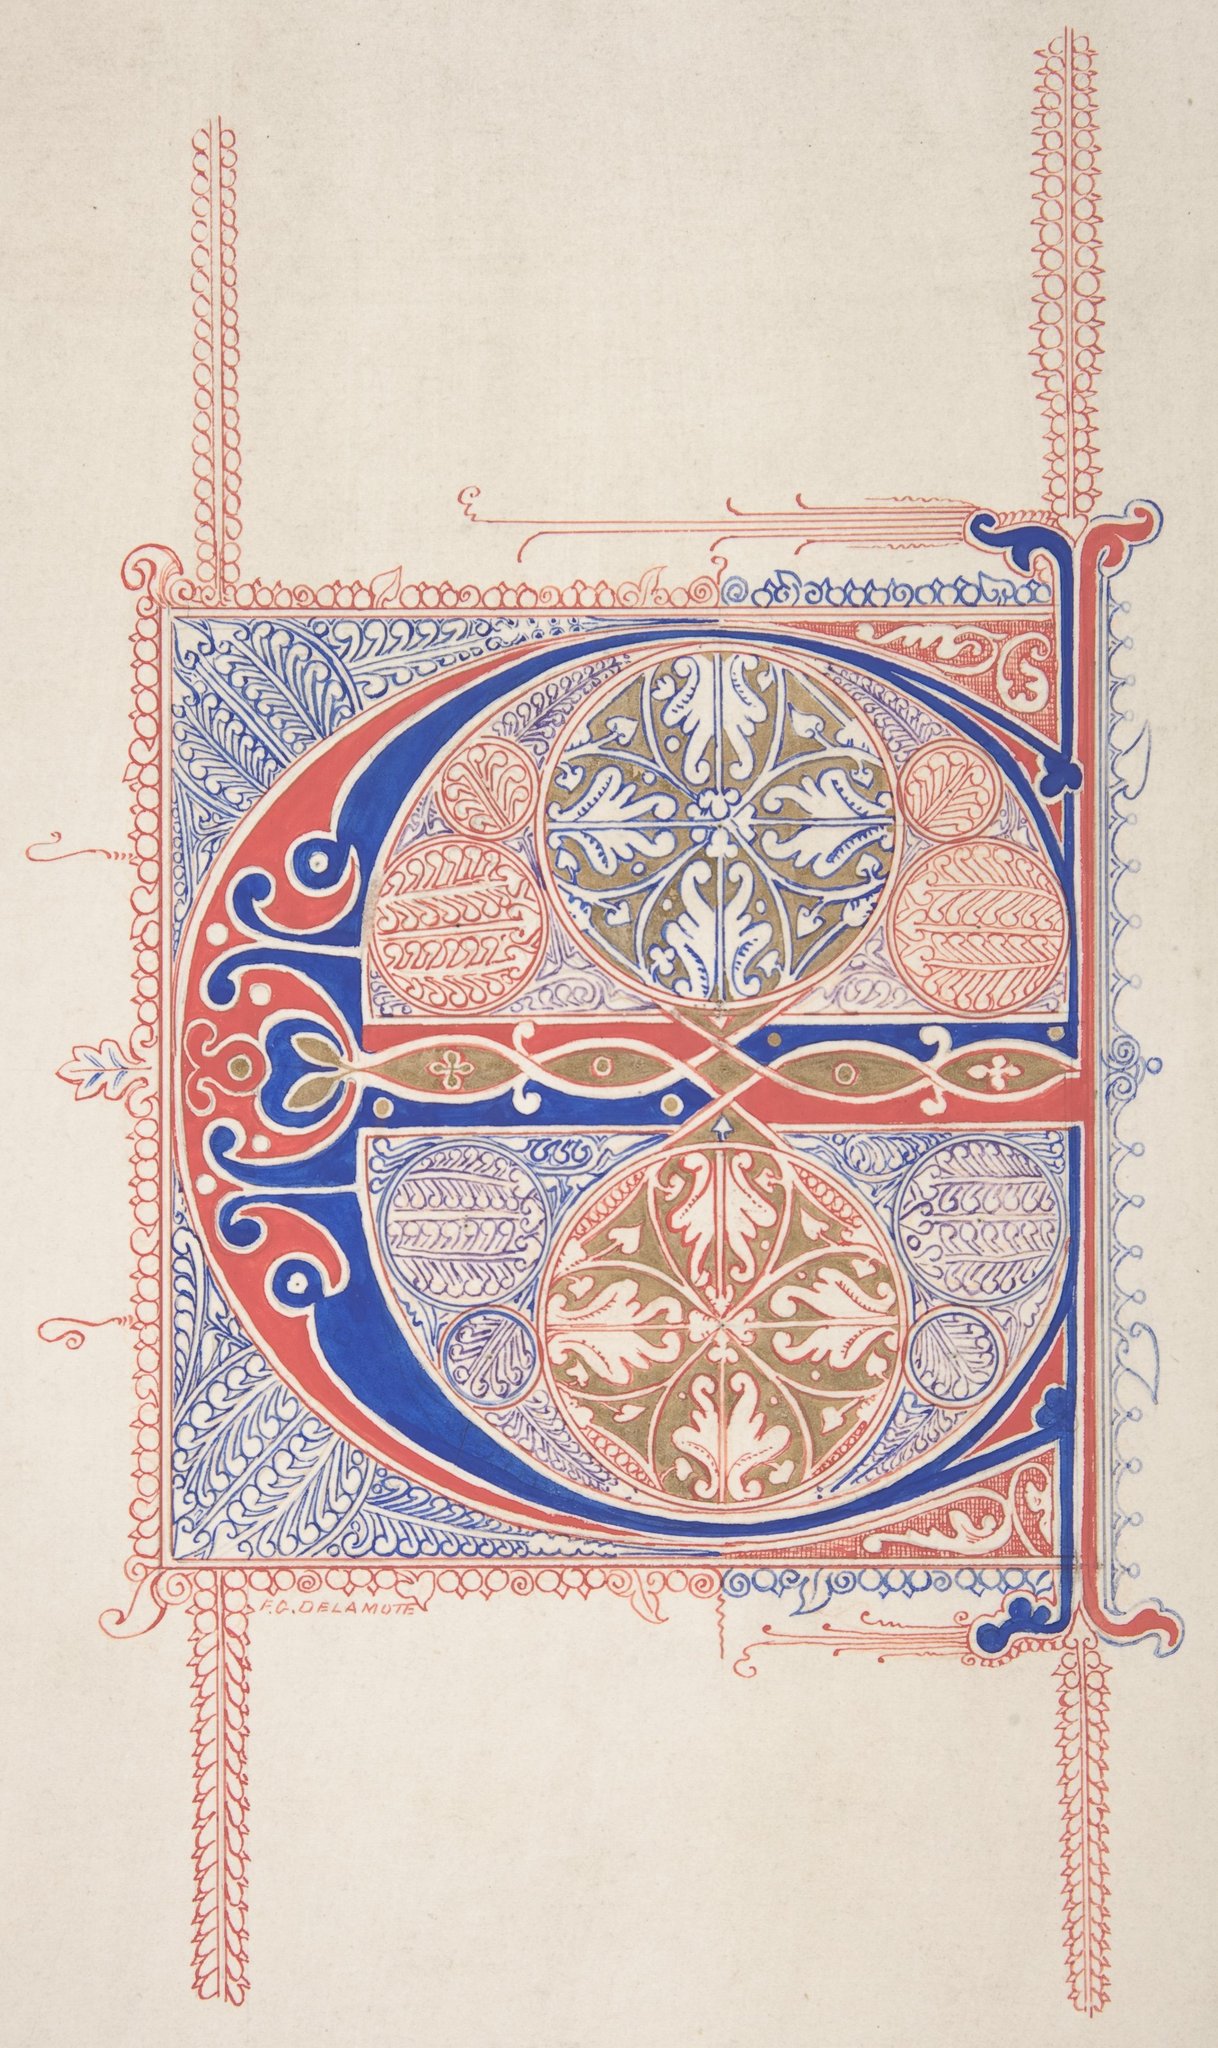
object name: drawing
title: Illuminated Initial "C"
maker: freeman gage delamotte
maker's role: artist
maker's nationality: british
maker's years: 1813-1862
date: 1830-1862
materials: gold, gouache, graphite, ink, watercolor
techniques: pen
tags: ornament